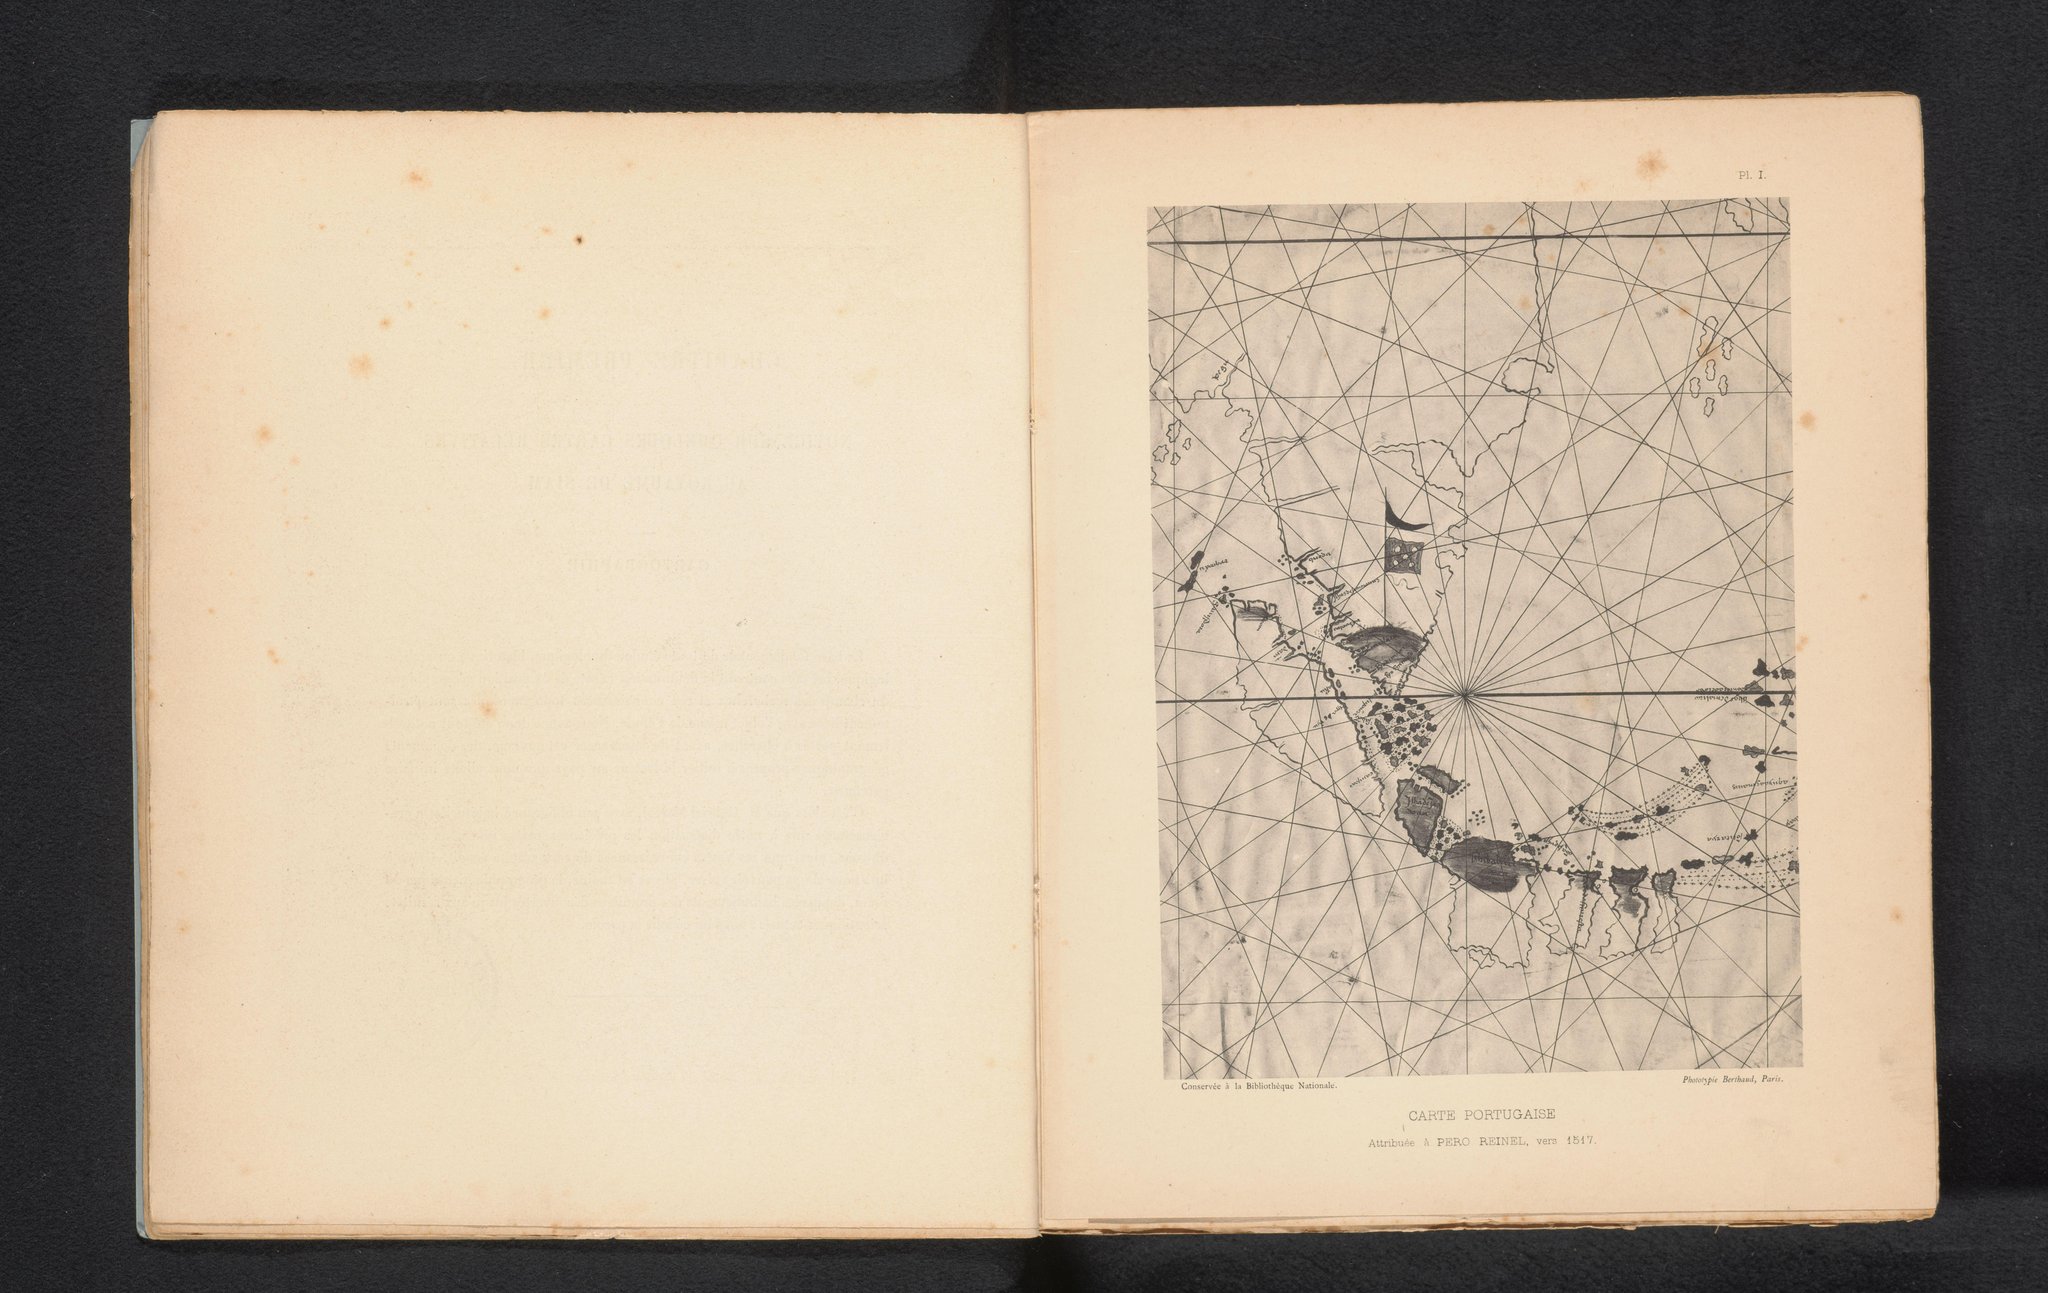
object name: photomechanical print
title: Reproductie van een landkaart door Pedro Reinel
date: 1890-1895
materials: paper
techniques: photograph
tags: maps, atlases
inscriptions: collector's mark: ‘Société d'Emulation de l'Ain/ Bourg/ Bibliothèque’, inscription: ‘Pl. I/ Conservée à la Bibliothèque Nationale’, inscription: ‘Attribuée à Pero Reinel, vers 1517’